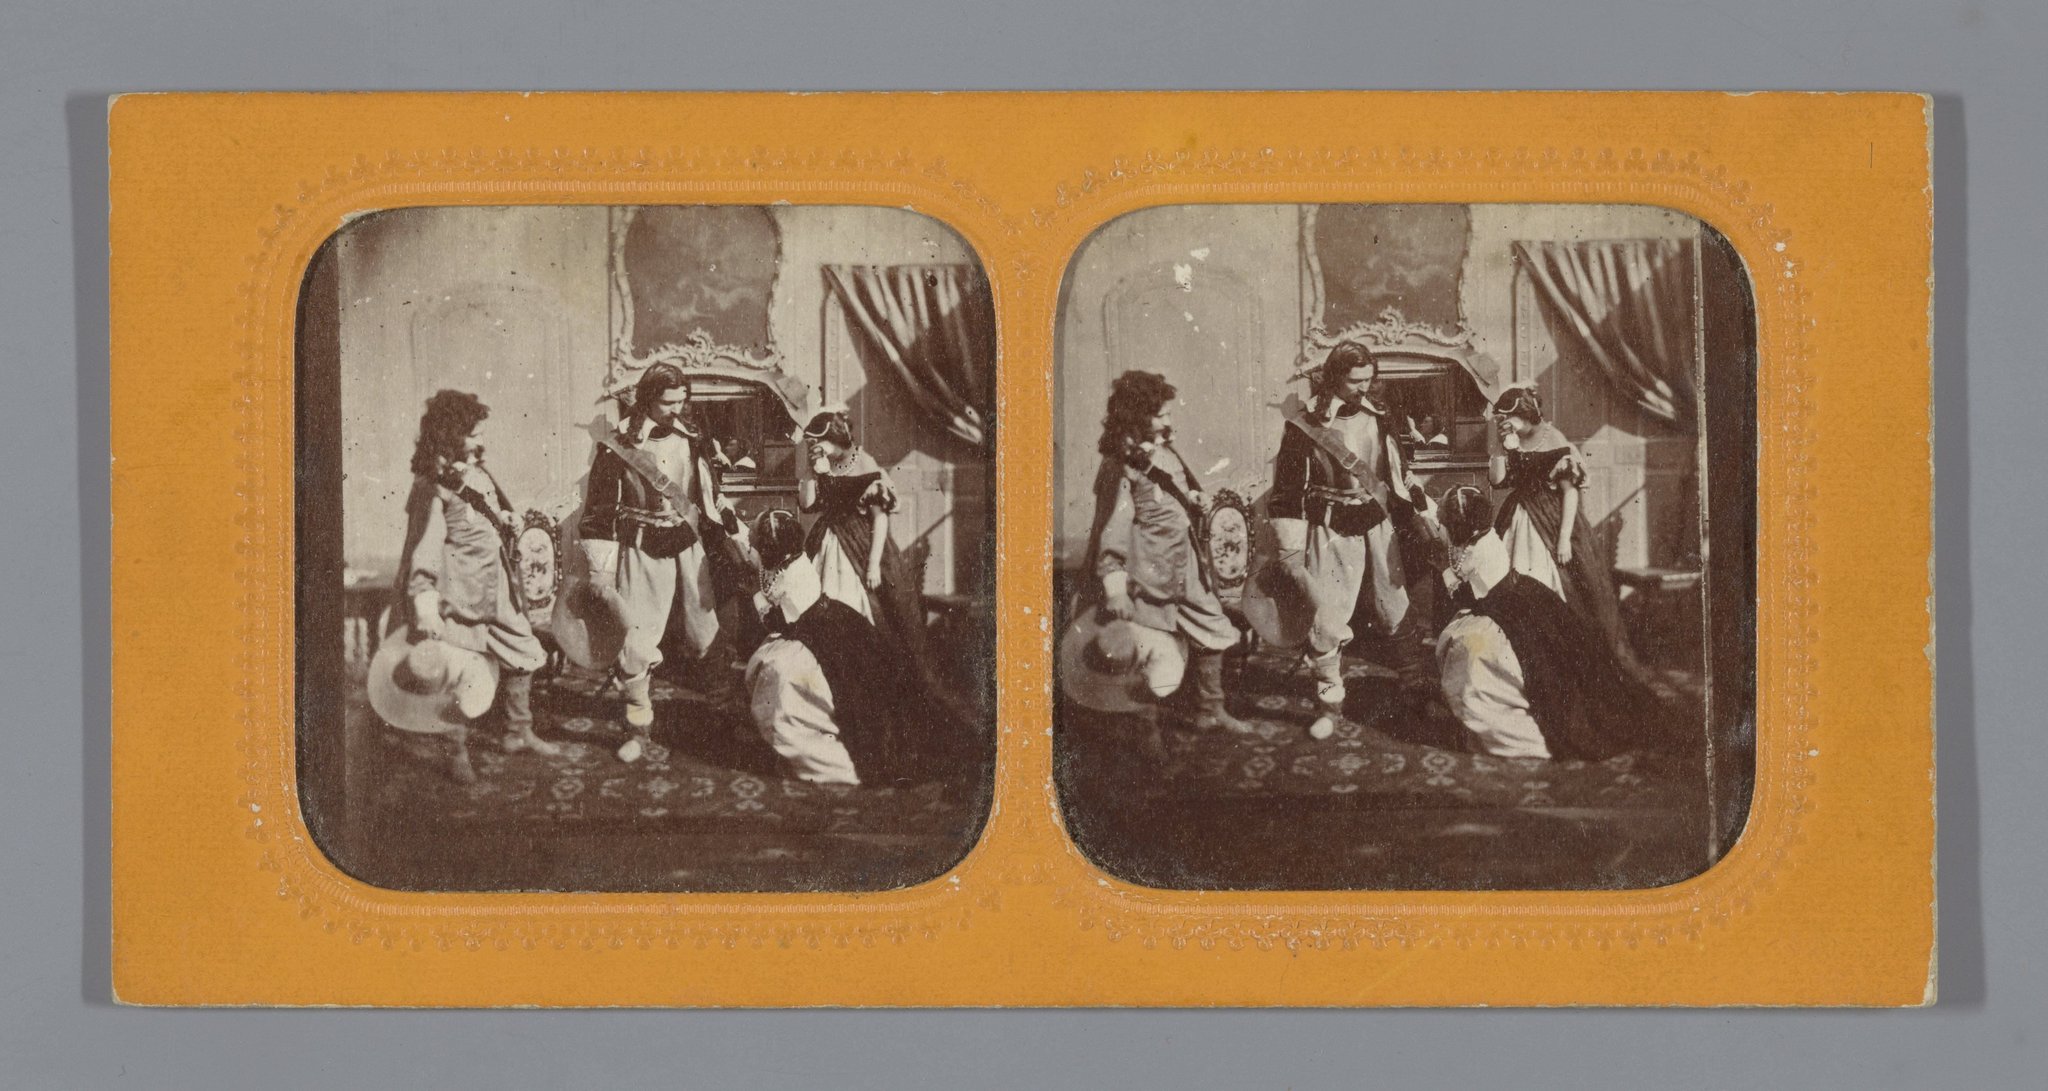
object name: tissue stereograph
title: Gezelschap in historische kleding met twee huilende en smekende vrouwen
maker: Anonymous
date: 1855-1875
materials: cardboard, paper, photographic support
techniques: albumen print, hand coloring, perforating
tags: weeping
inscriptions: retailer's mark: ‘J. C. DE BESTE Wz./ GOES’, number: ‘5’